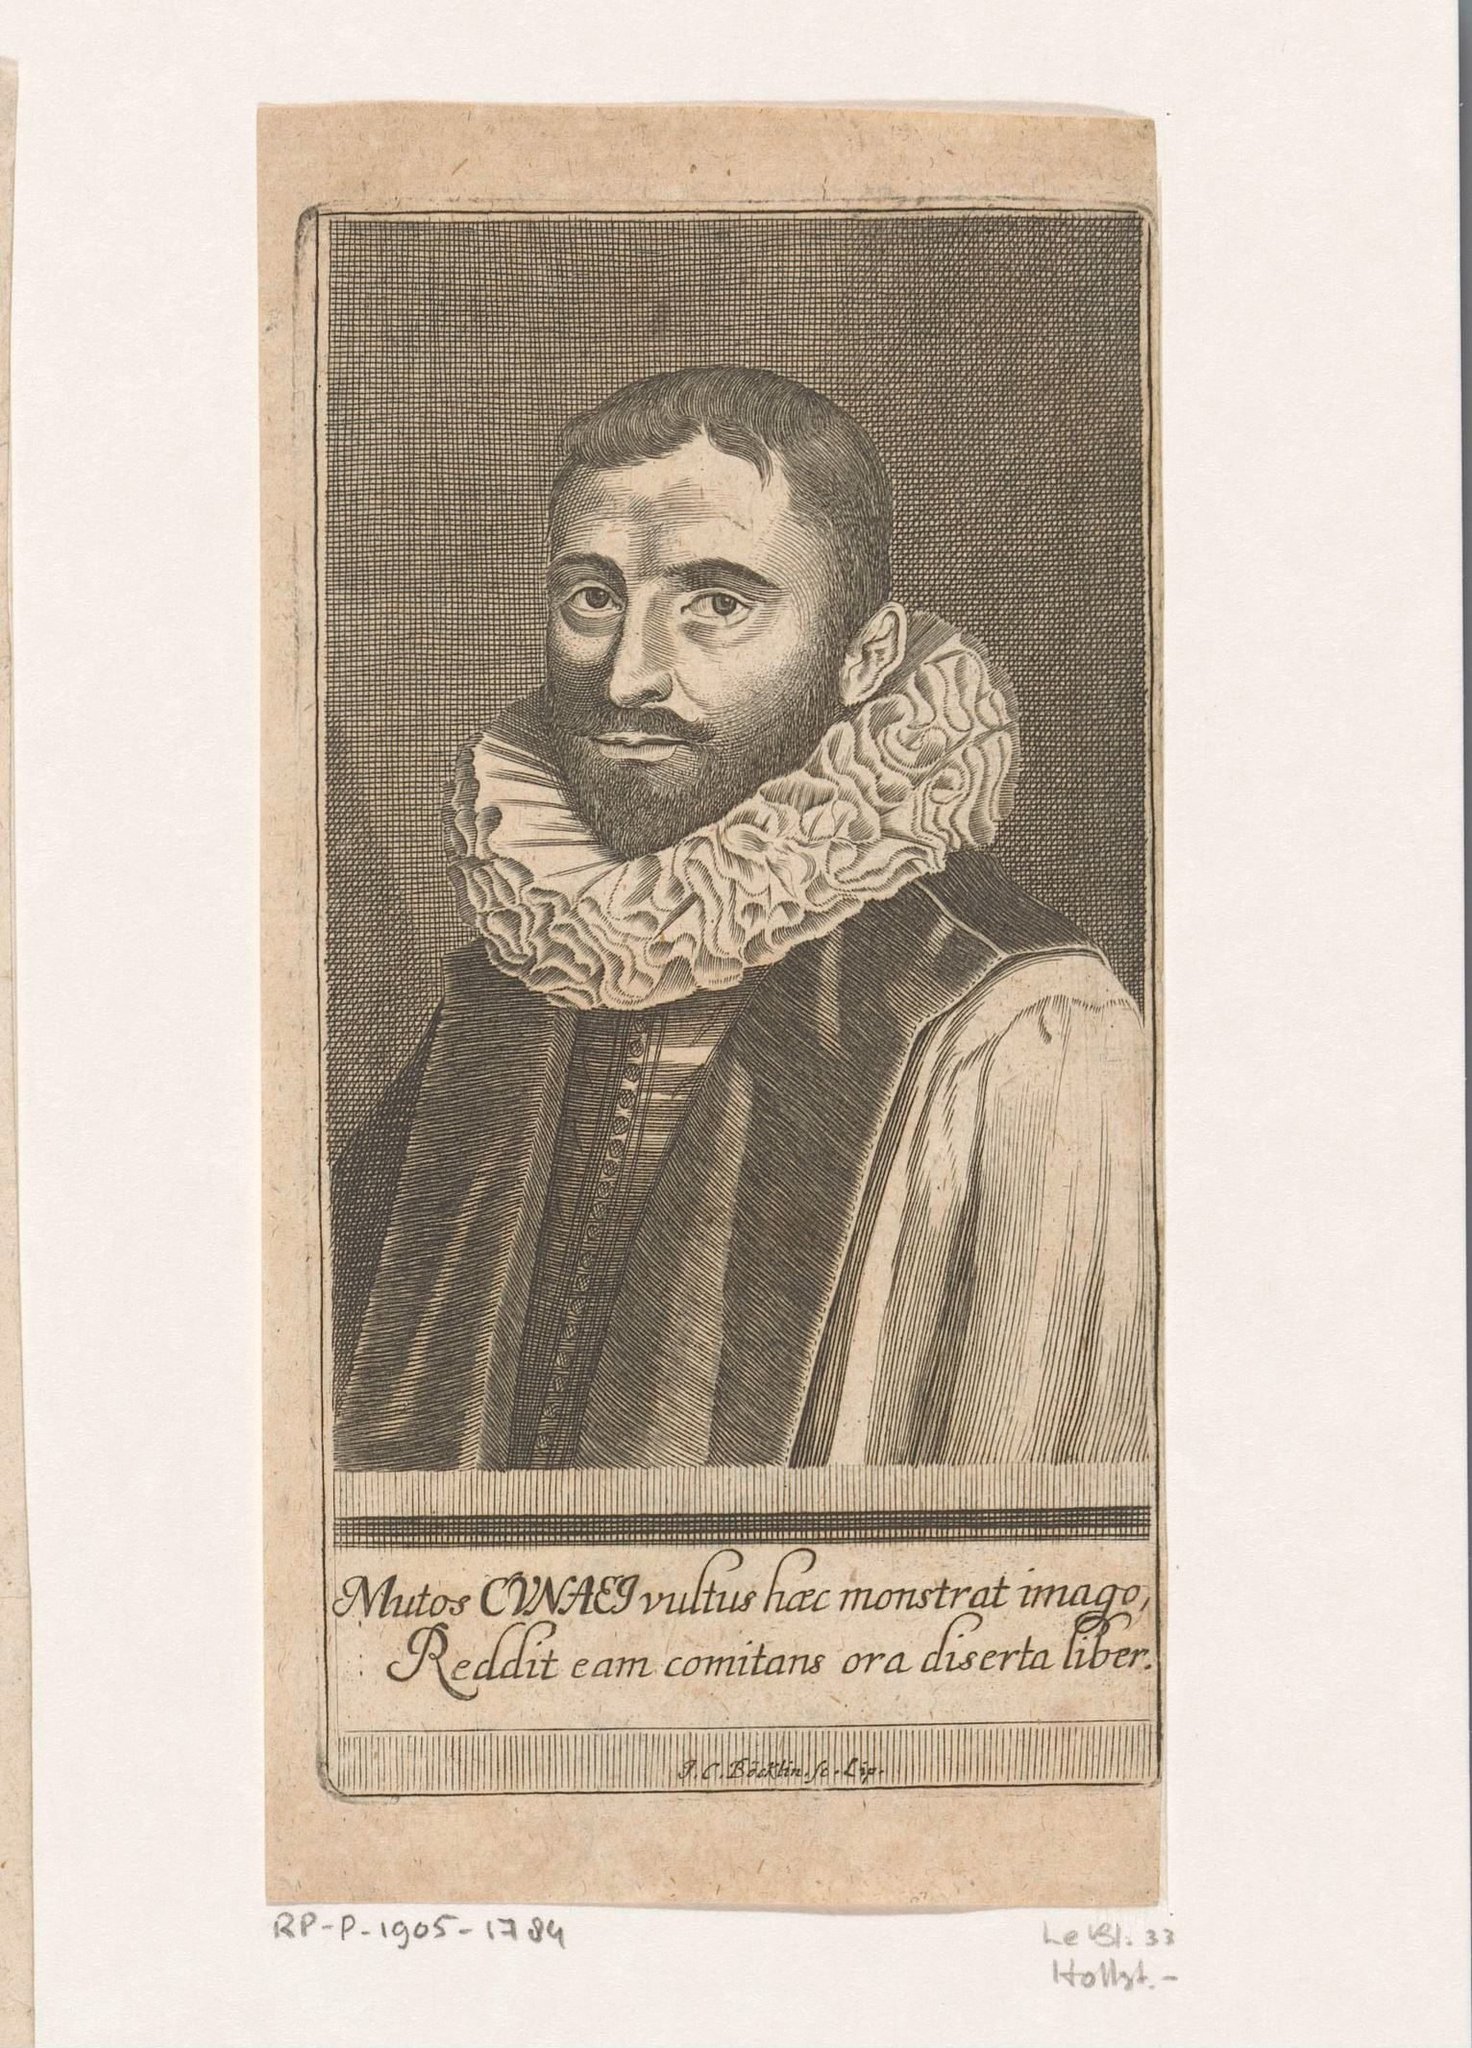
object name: print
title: Portret van Petrus Cunaeus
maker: johann christoph boecklin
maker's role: print maker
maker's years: 1657-1709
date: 1667-1709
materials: paper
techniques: engraving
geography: leipzig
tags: flushing, historical persons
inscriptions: collector's mark: Lugt 2228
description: Prent ook gebruikt in: Cunaeus, Petrus. Orationes argumenti varii (...). Leipzig: Moritz Georg Weidmann, 1720.